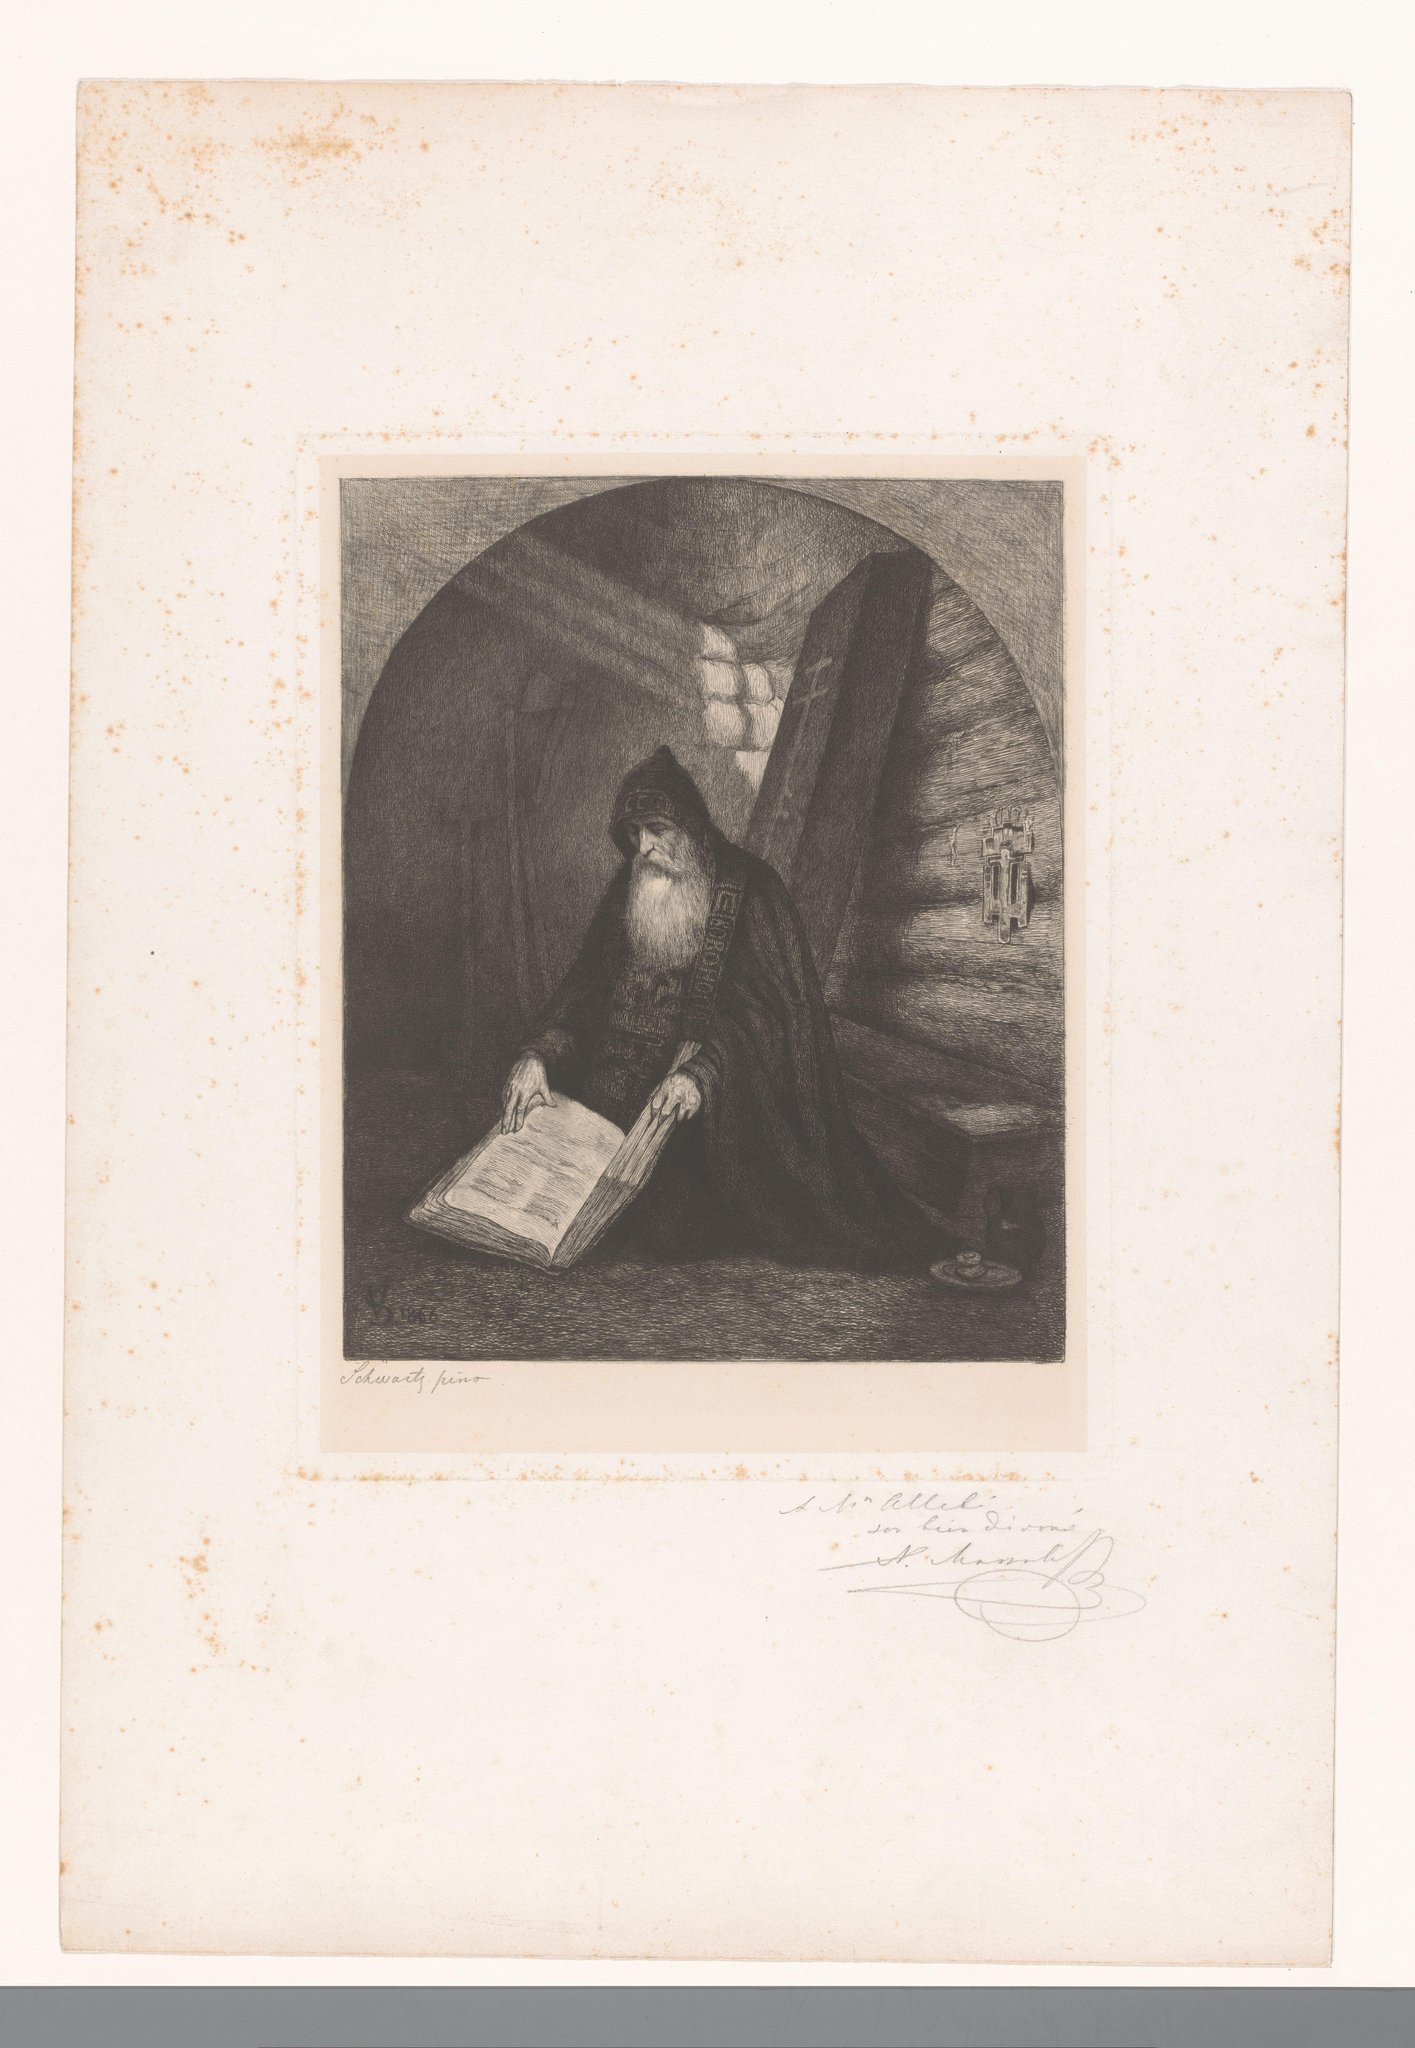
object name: print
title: Orthodoxe monnik of kluizenaar knielend met een open boek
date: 1857-1913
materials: paper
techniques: drypoint, etching, intaglio, roulette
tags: monastic orders, monastic life ~ eastern, greek and russian orthodox churches, book - mm - book open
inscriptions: annotation: ‘A mr. Allebé [...] [signatuur Mosolov]’, collector's mark: Lugt 2233